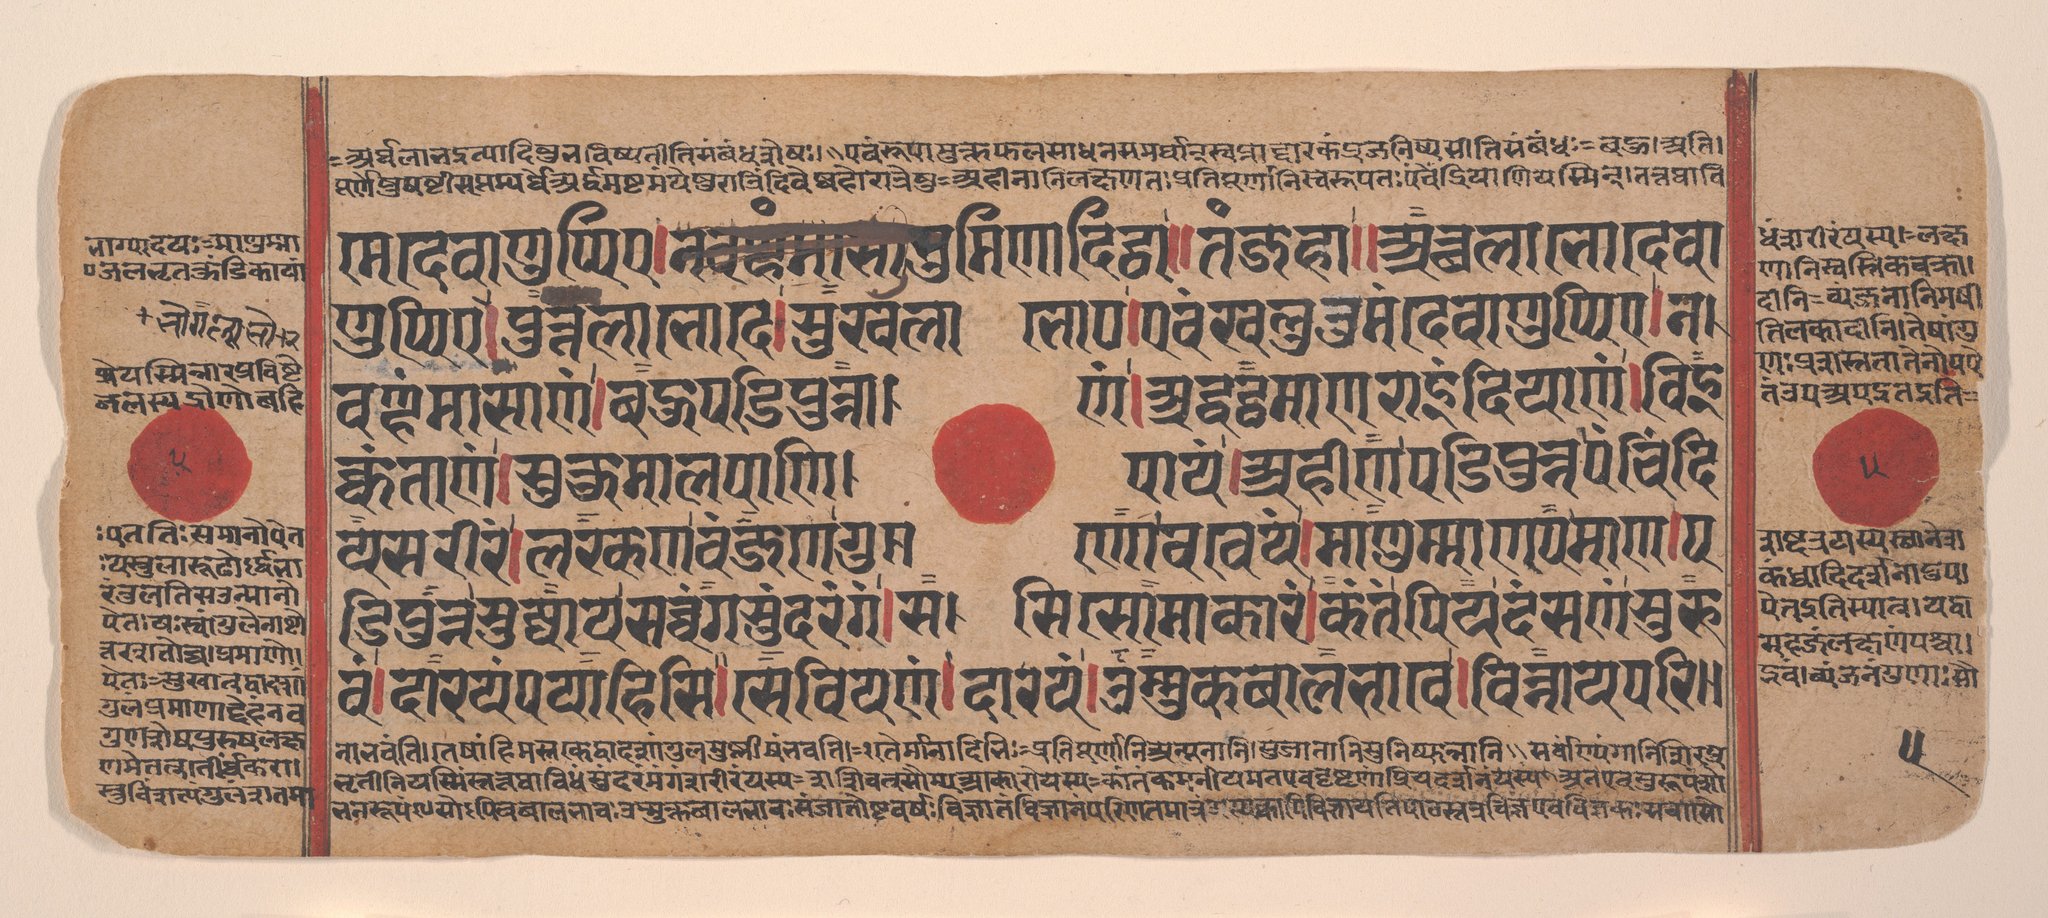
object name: folio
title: Page from a Dispersed Kalpa Sutra (Jain Book of Rituals)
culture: indian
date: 1401-1500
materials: gold, ink, paper, watercolor